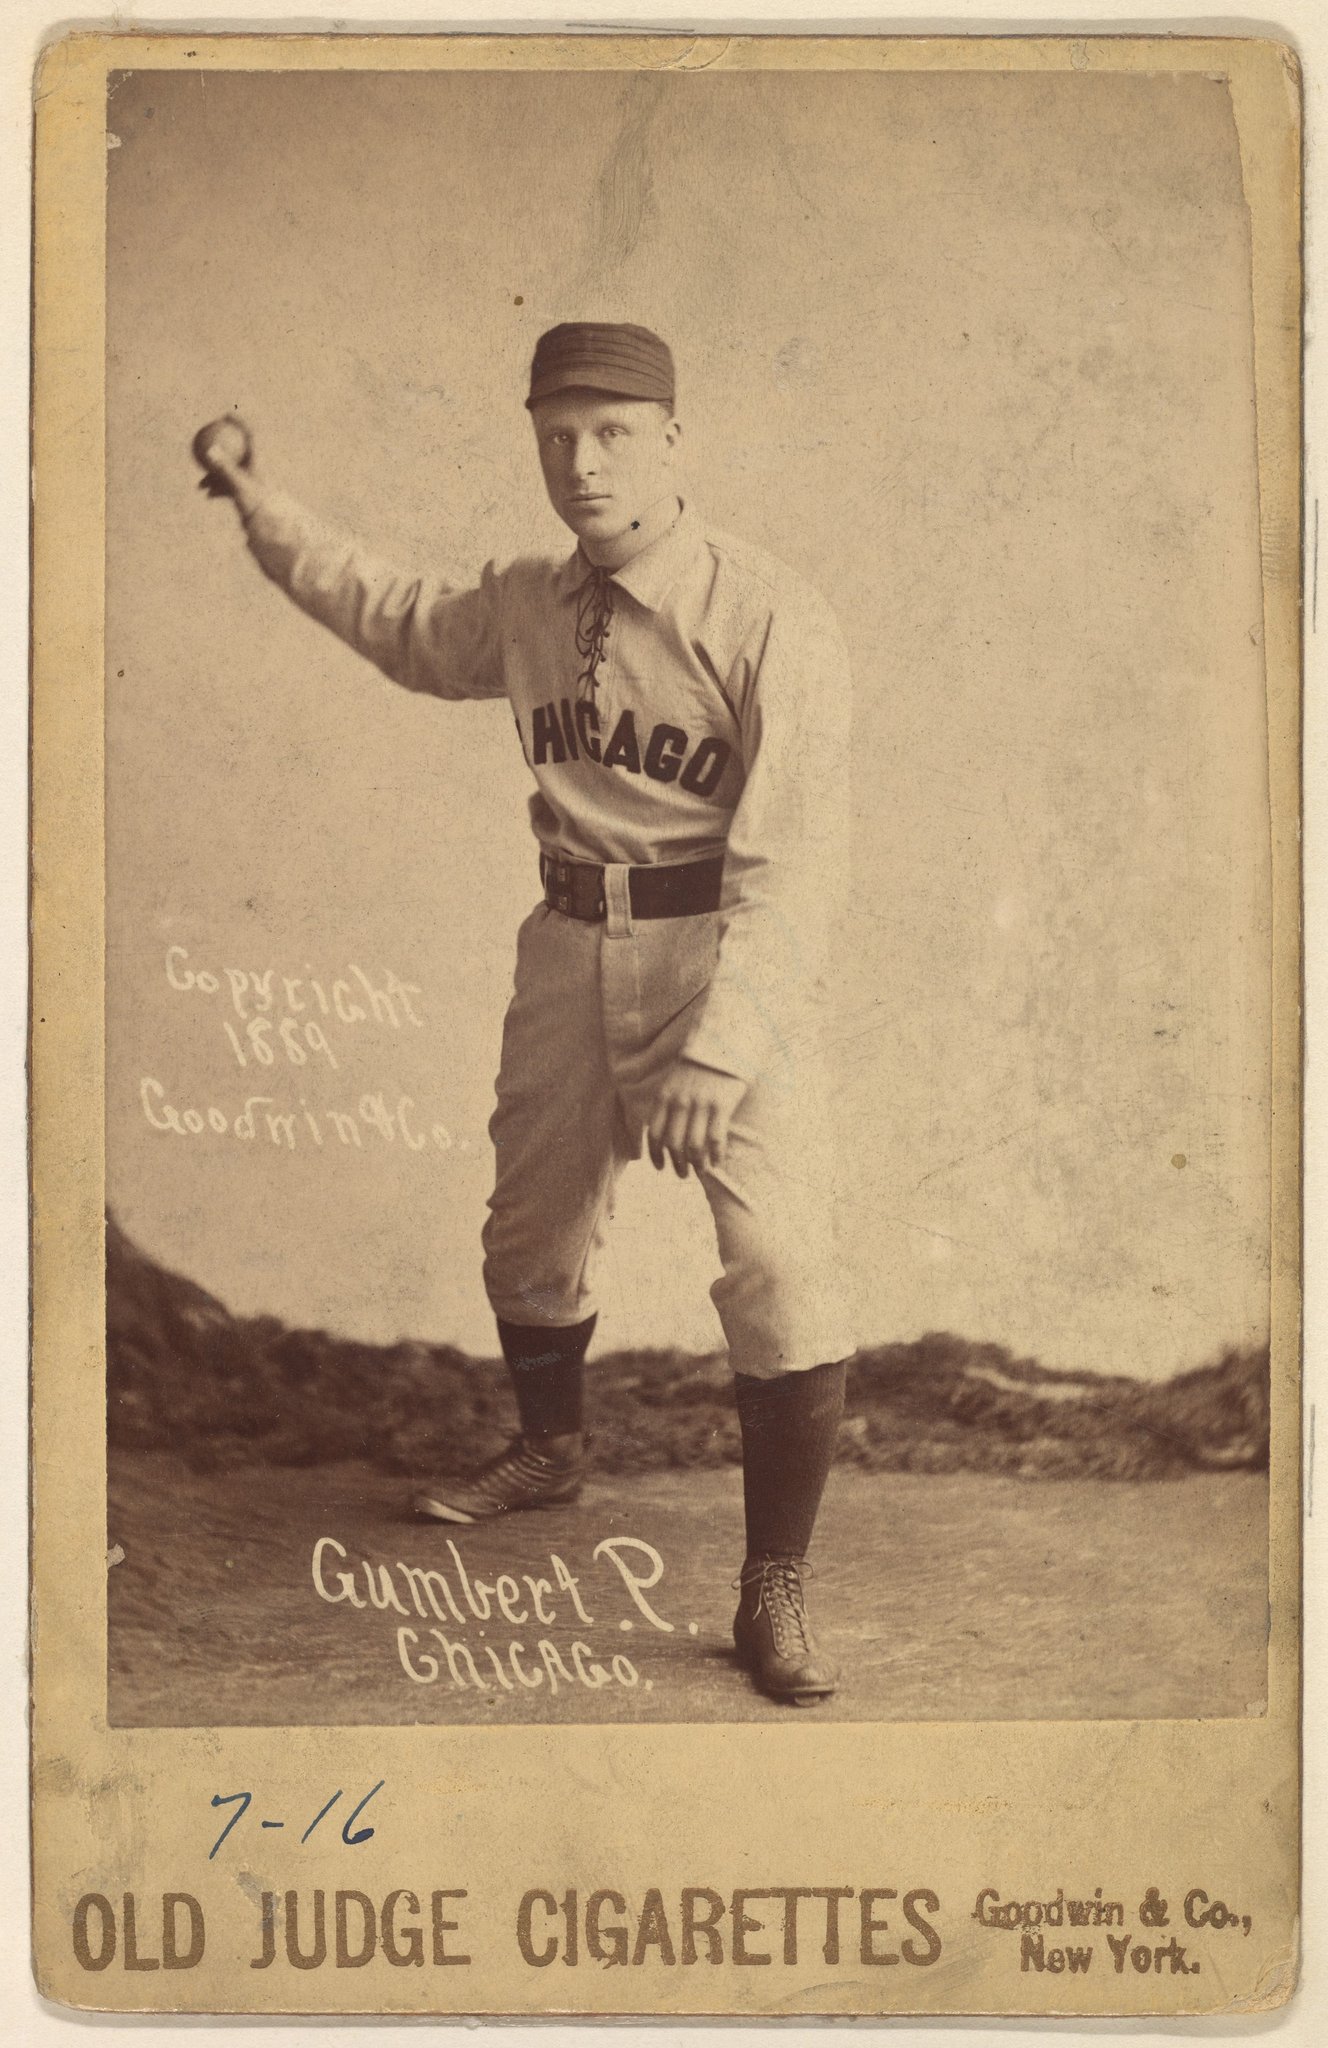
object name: baseball card, photograph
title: Ad Gumbert, Pitcher, Chicago, from the series Old Judge Cigarettes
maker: goodwin & company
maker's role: publisher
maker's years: 1850-1950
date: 1889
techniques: albumen silver print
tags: men,portraits,baseball,athletes